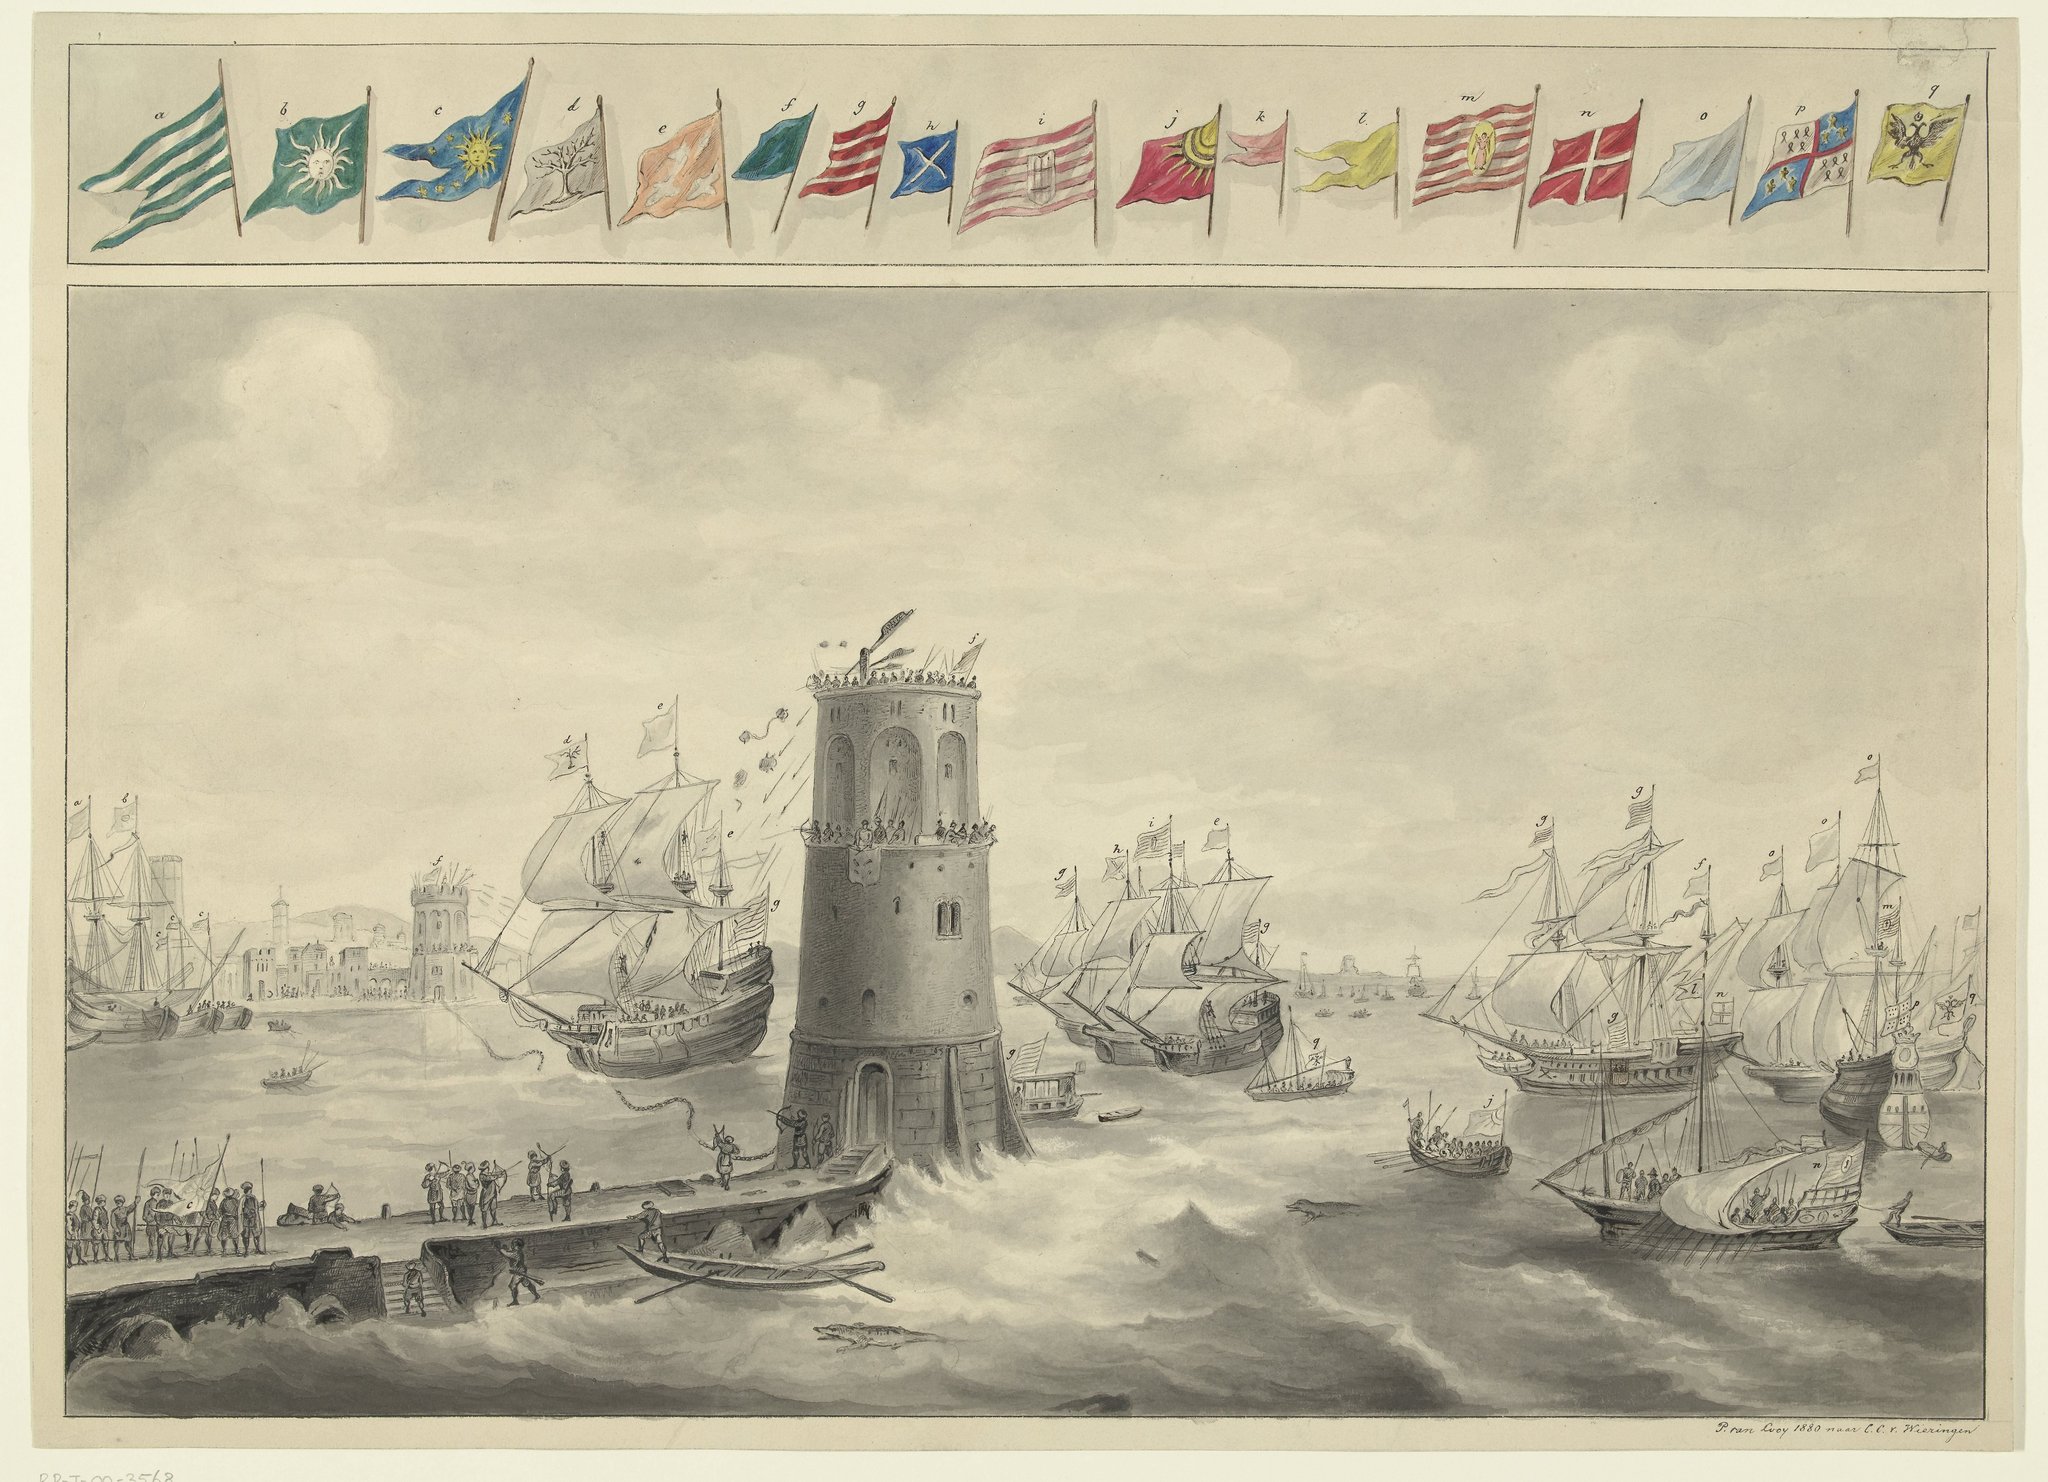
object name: history print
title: Inname van Damiate, 1219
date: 1880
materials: ink, paper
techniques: brush, pen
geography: netherlands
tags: haarlem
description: De inname van de stad Damiate op 15 november 1219. Gezicht op de Haarlemse en Friese schepen in de haven en het doorvaren van de ketting. Boven de voorstelling een rij van 17 vlaggen. De vlaggen en details in de voorstelling zijn aangeduid met een letter, maar de bijbehorende legenda ontbreekt.